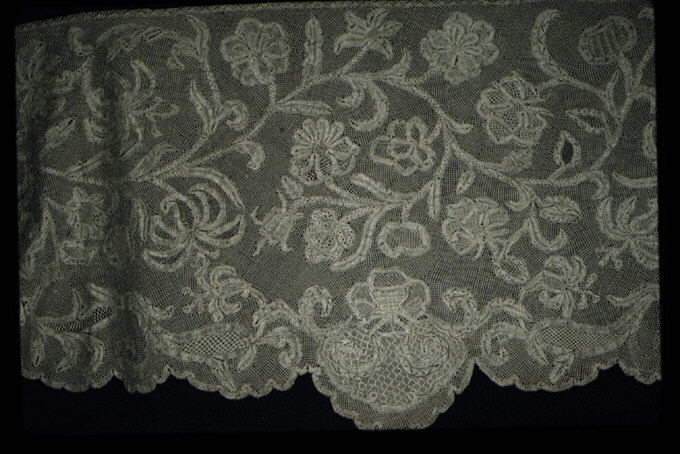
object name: border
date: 1701-1800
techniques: lace